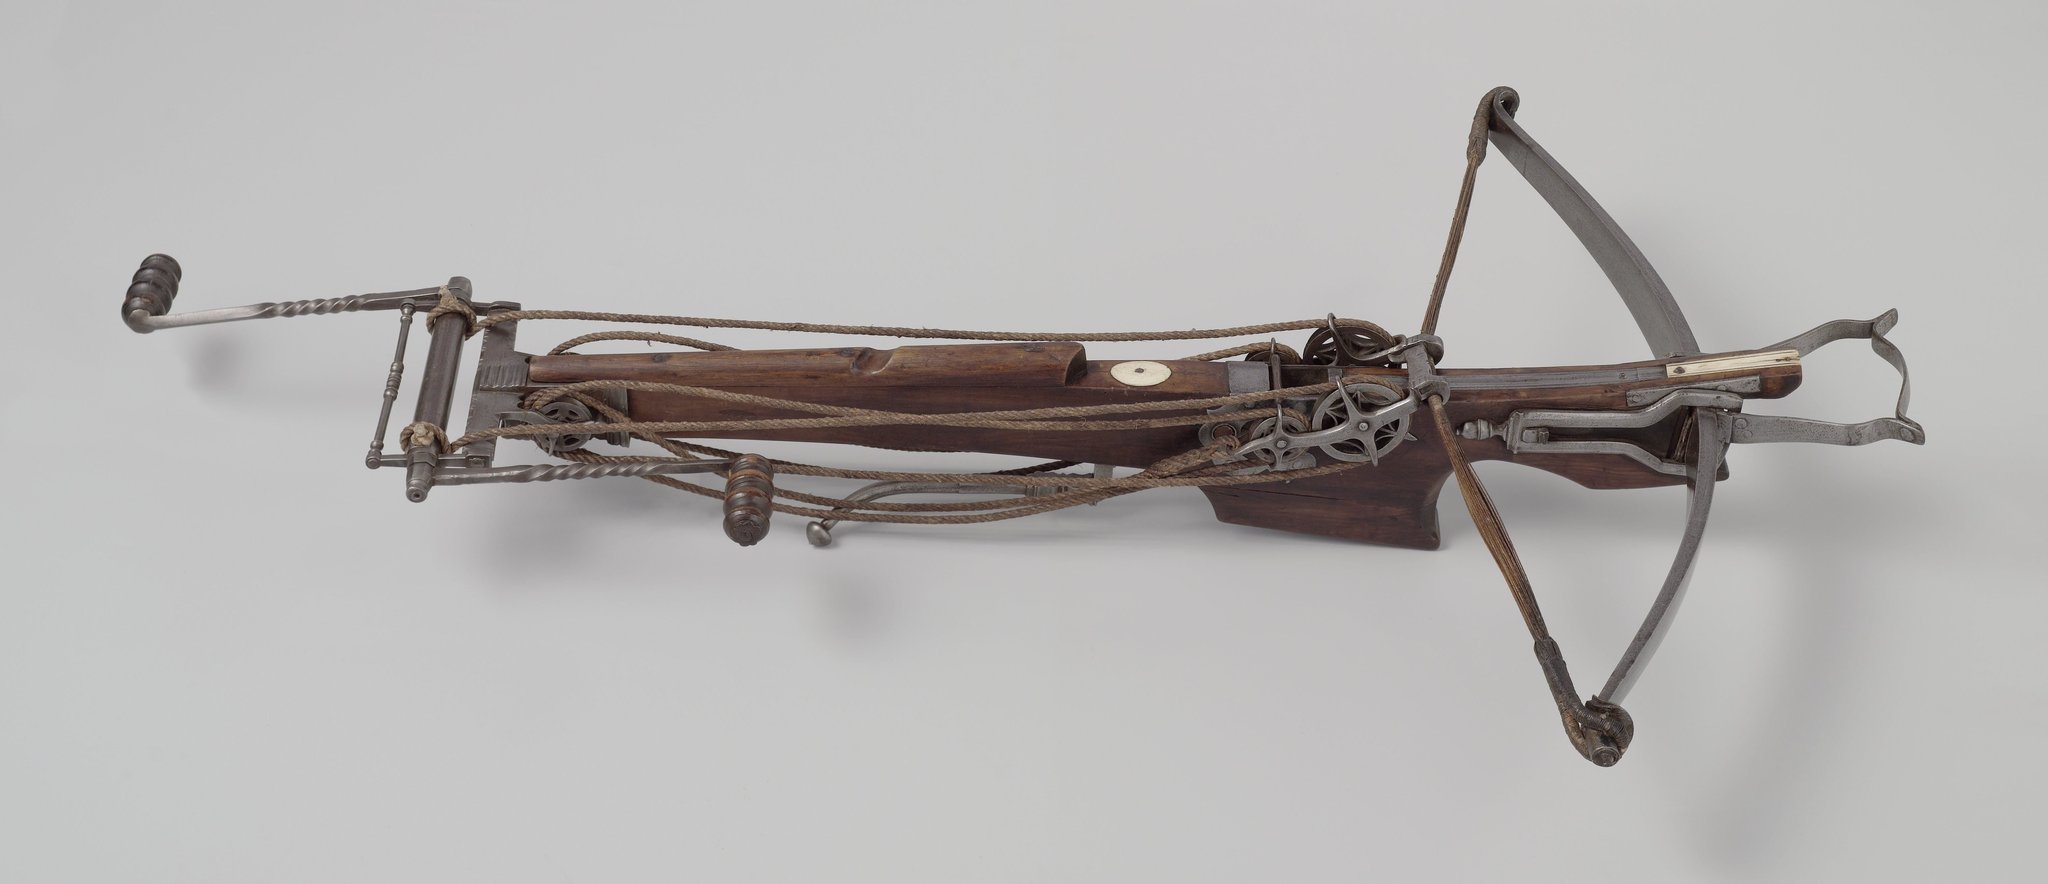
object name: kruisboog, armborst, voetboog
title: Crossbow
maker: Anonymous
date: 1500-1600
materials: bone, iron, steel, wood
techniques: cutting, forging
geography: low countries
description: A crossbow is a heavy weapon that could shoot arrows with much greater force than a longbow. Instead of drawing the crossbow by hand, the marksman used a reel. Crossbow arrows, however, could not go further than thirty metres. Moreover, it took quite some time to draw the crossbow.